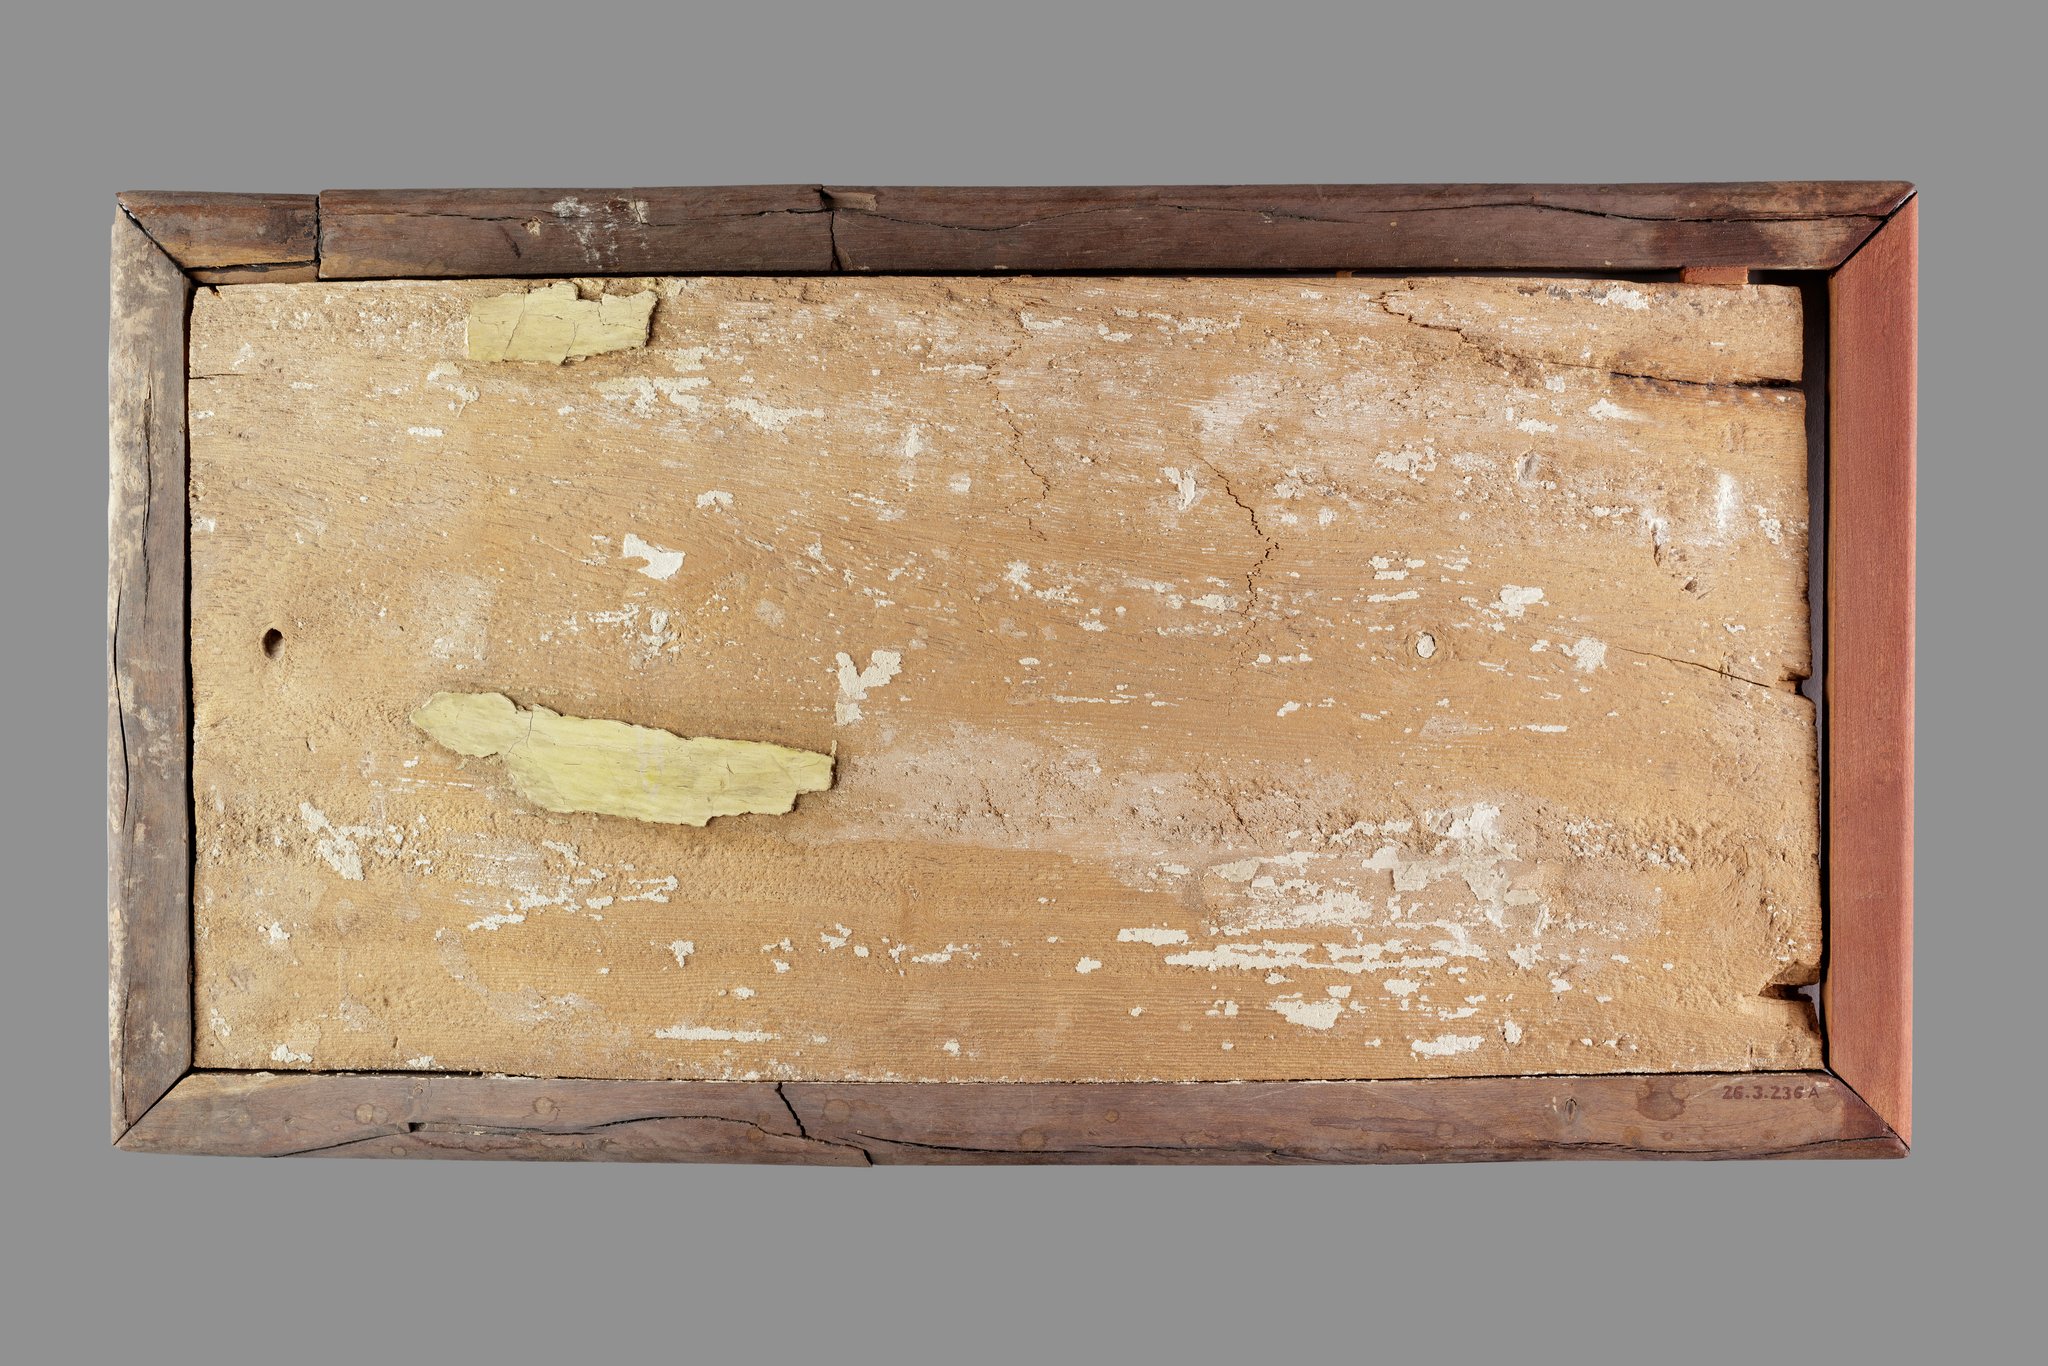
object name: writing board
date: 2030-1981 BCE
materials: wood, gesso, paint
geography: egypt